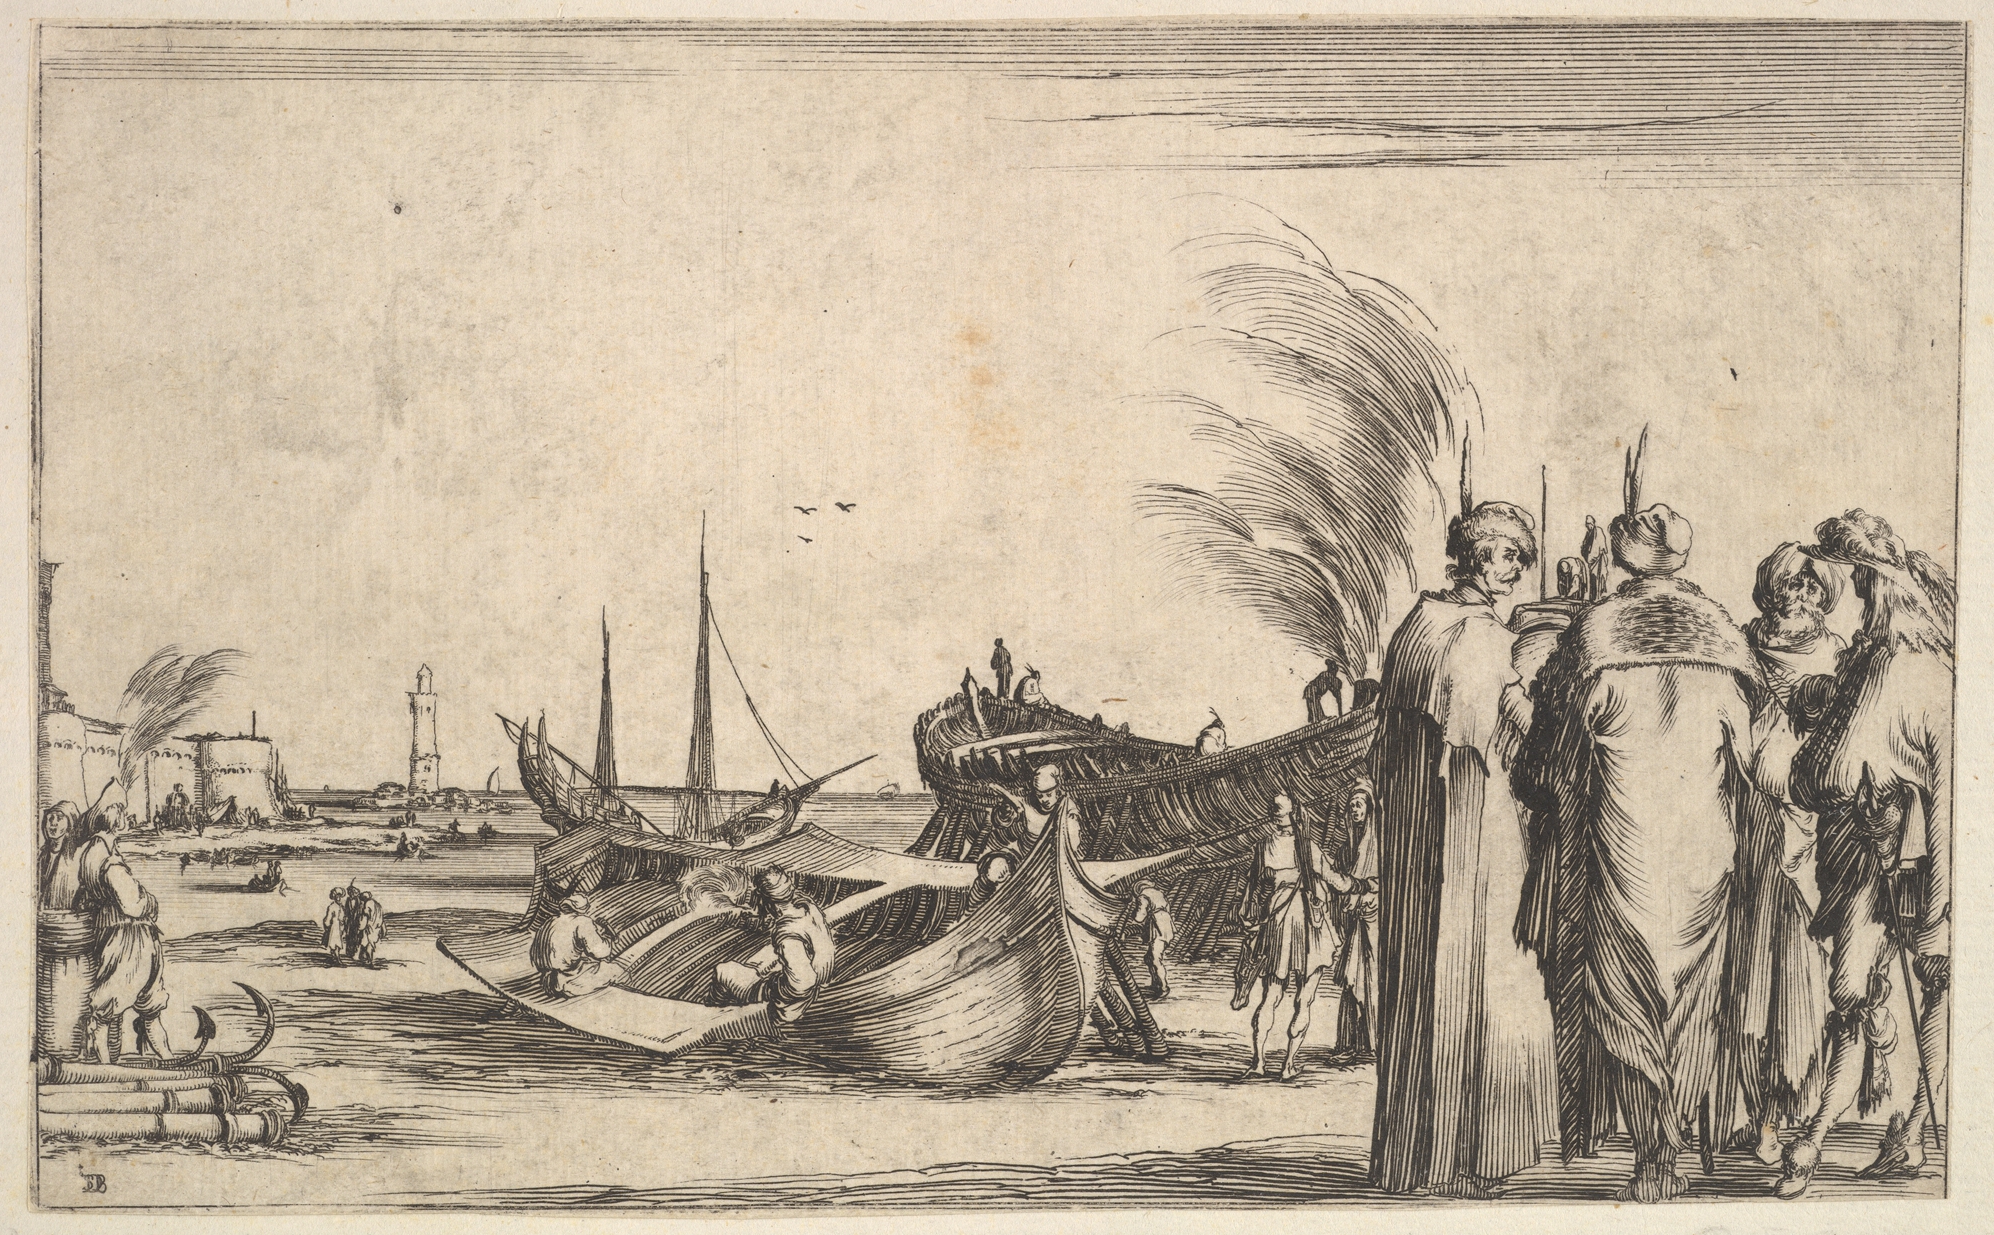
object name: print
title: Three Turks and an Italian gentleman standing to right, men work on small boats in center, a fortress to left in the background, from "Set of eight nautical landscapes" (Suite de huit Marines)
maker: stefano della bella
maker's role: artist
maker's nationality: italian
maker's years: 1610-1664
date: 1639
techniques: etching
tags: men,working,boats